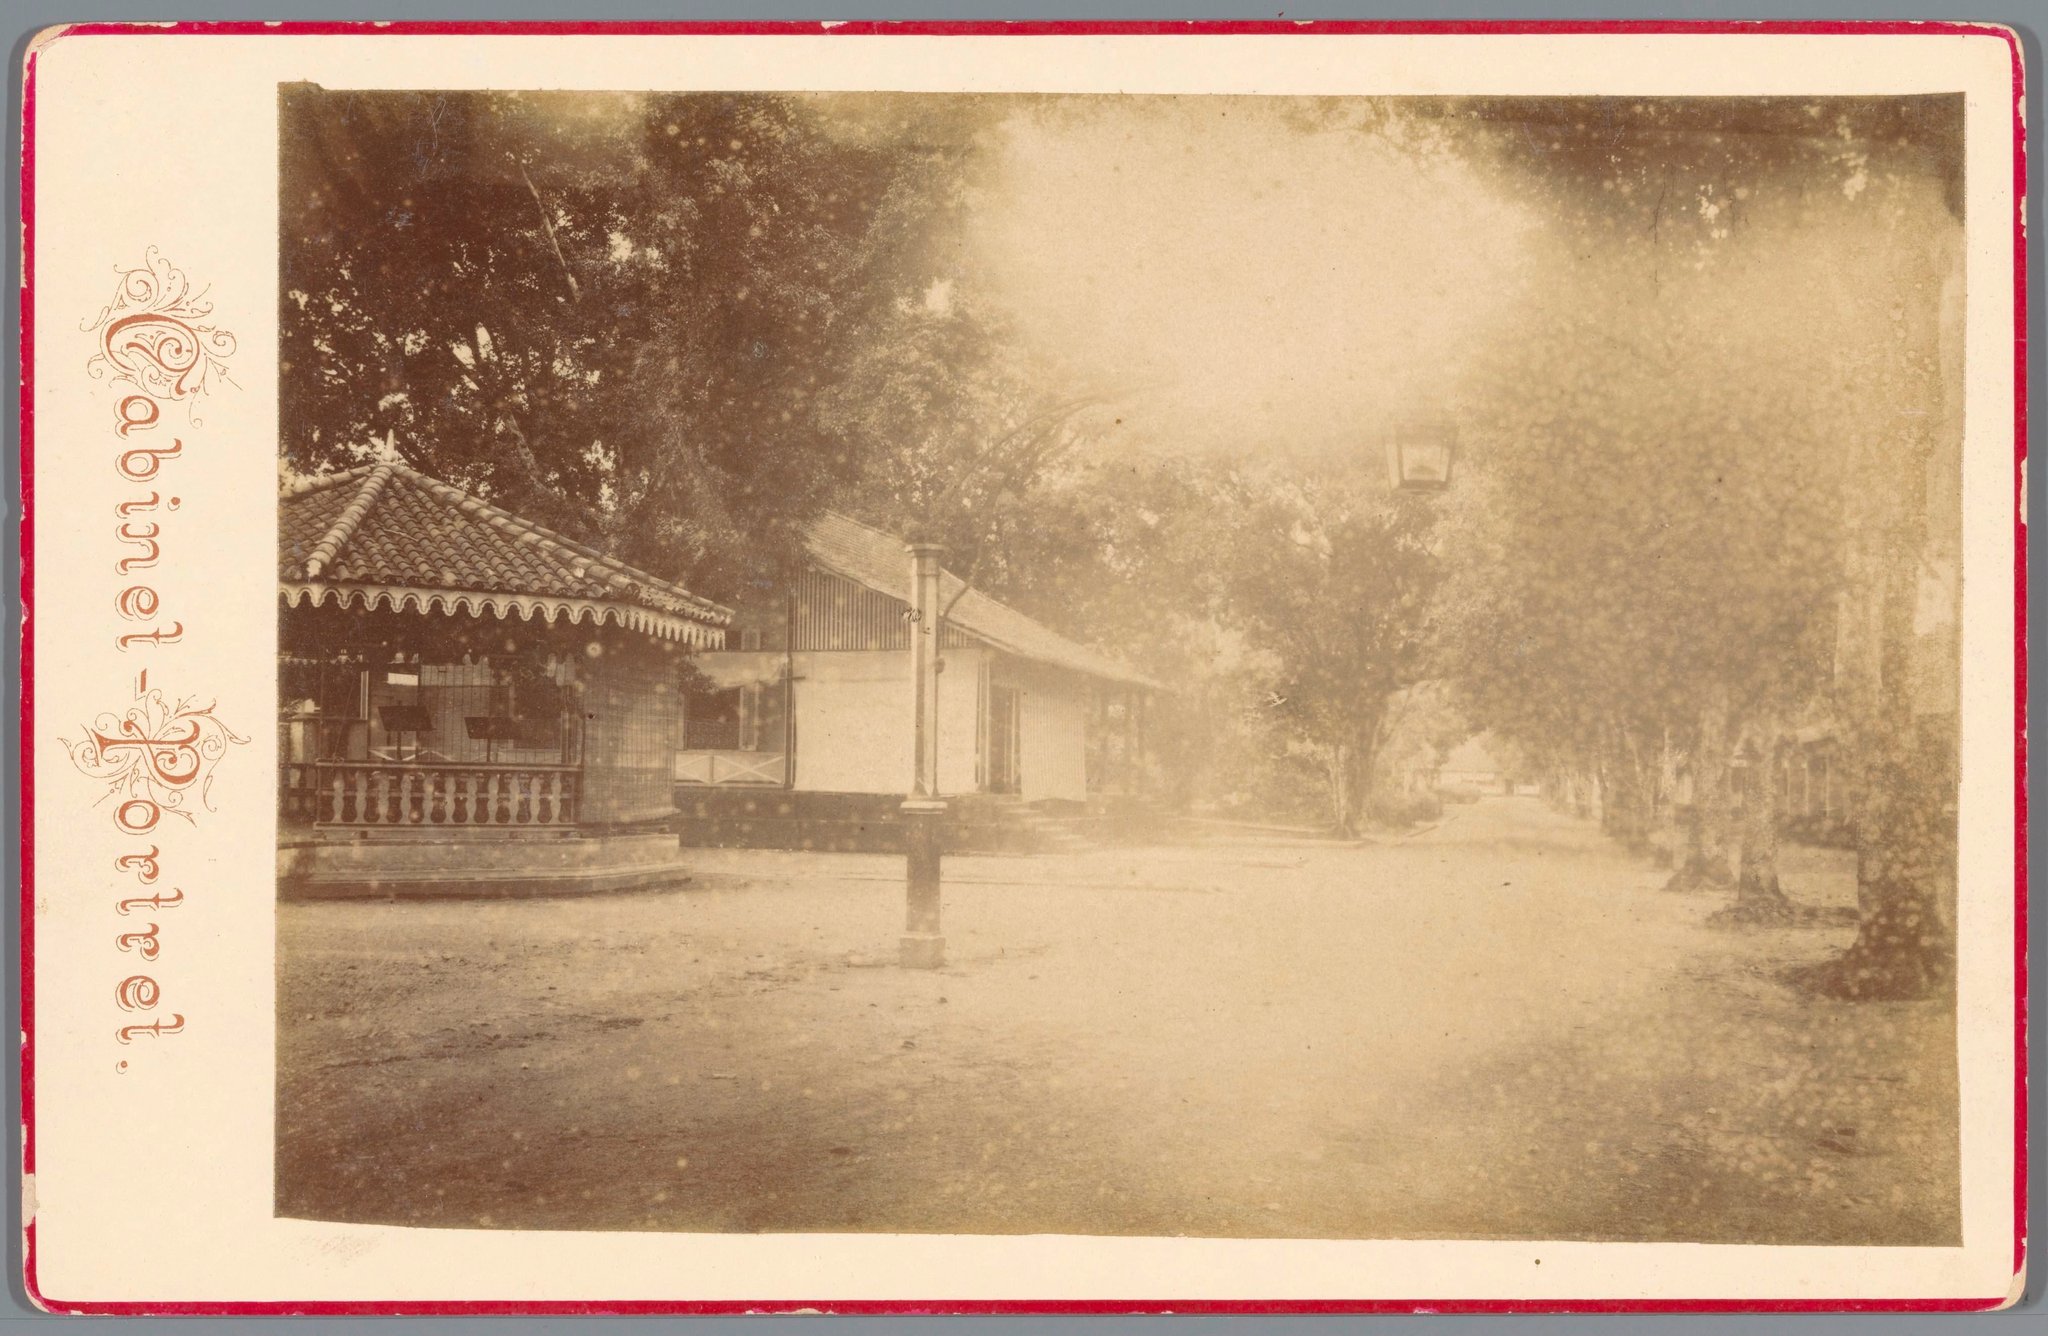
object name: cabinet photograph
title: Straat in Palembang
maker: Anonymous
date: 1890-1910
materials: cardboard, paper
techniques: albumen print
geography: palembang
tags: street, palembang (city)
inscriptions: inscription: ‘Cabinet-Portret’